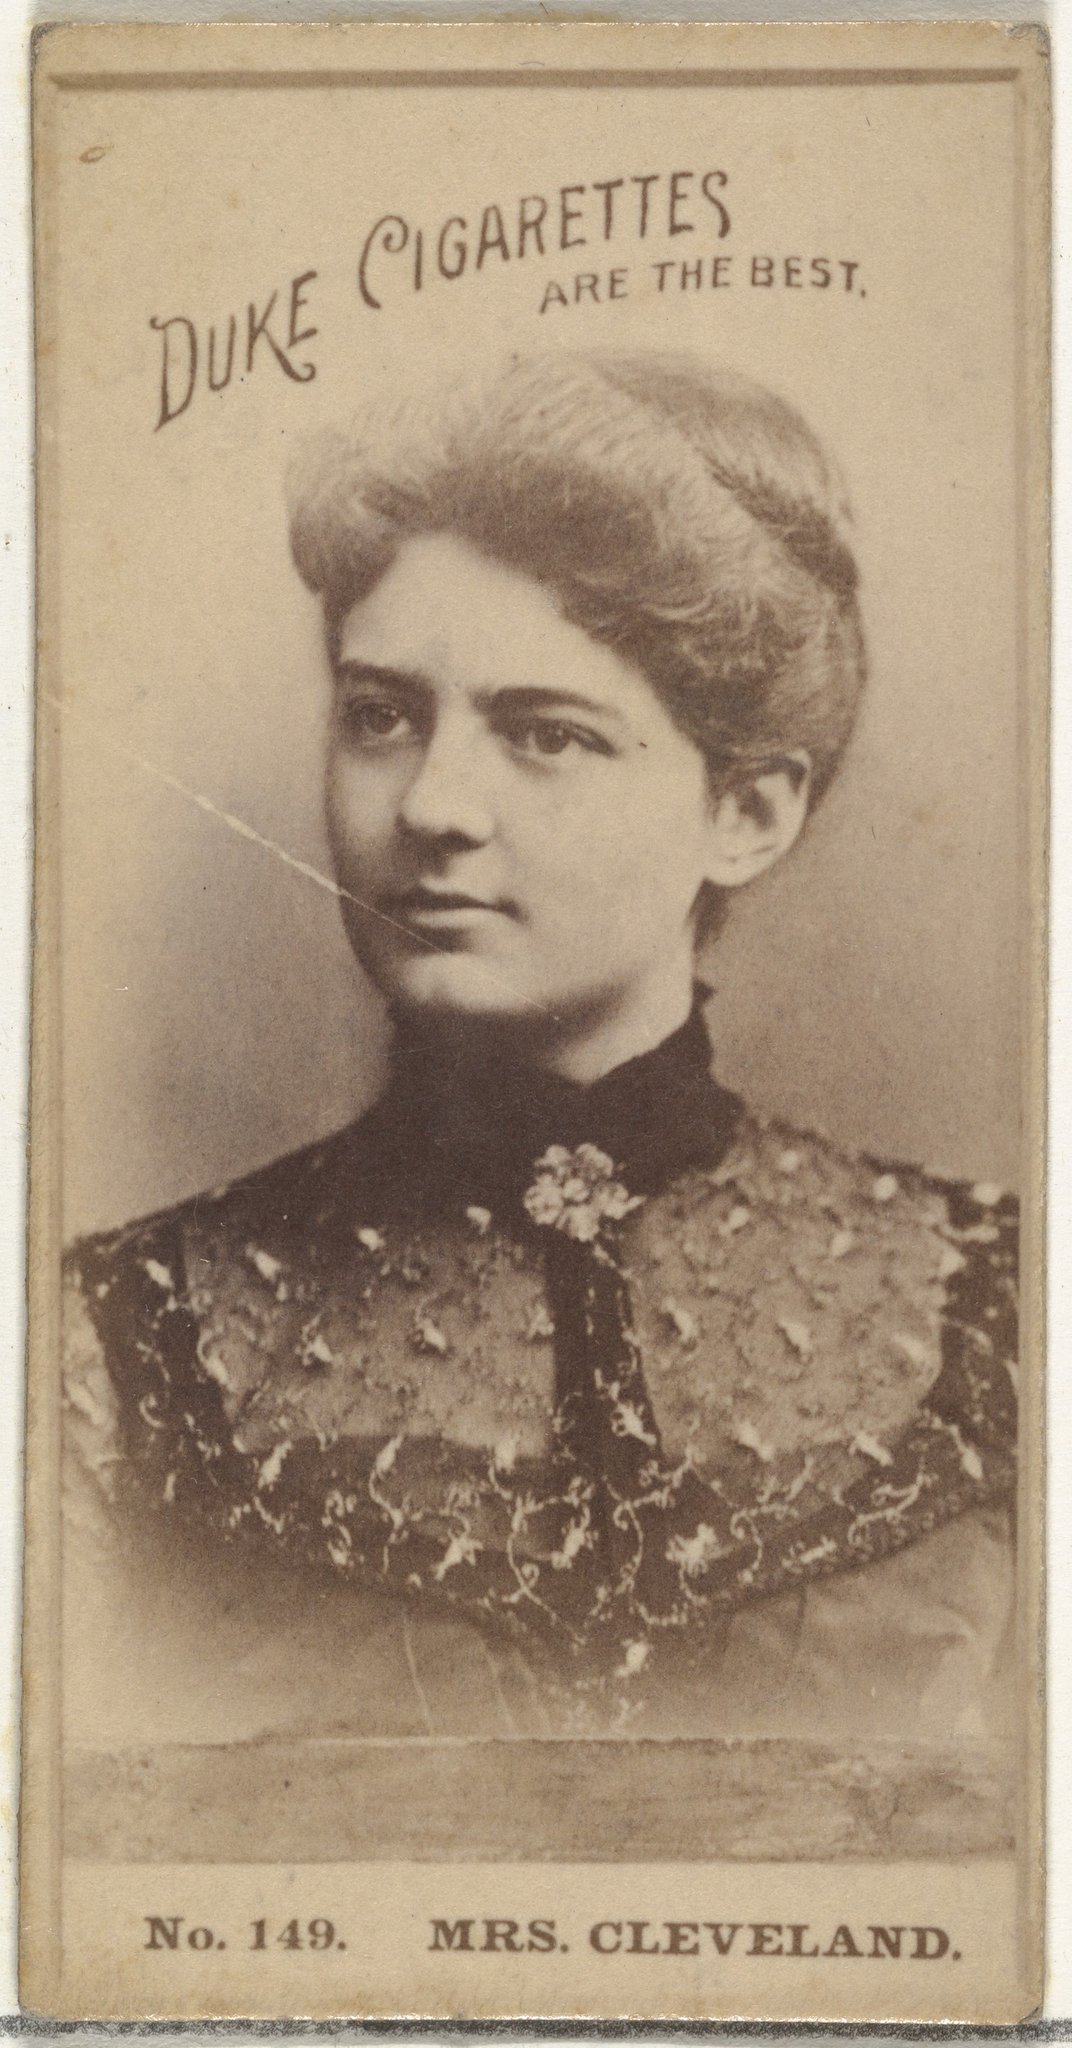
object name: photograph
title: Card Number 149, Mrs. Cleveland, from the Actors and Actresses series (N145-6) issued by Duke Sons & Co. to promote Duke Cigarettes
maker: w. duke, sons & co.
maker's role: publisher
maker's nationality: american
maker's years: 1870-1920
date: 1880-1889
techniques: albumen silver print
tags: portraits,women,actresses